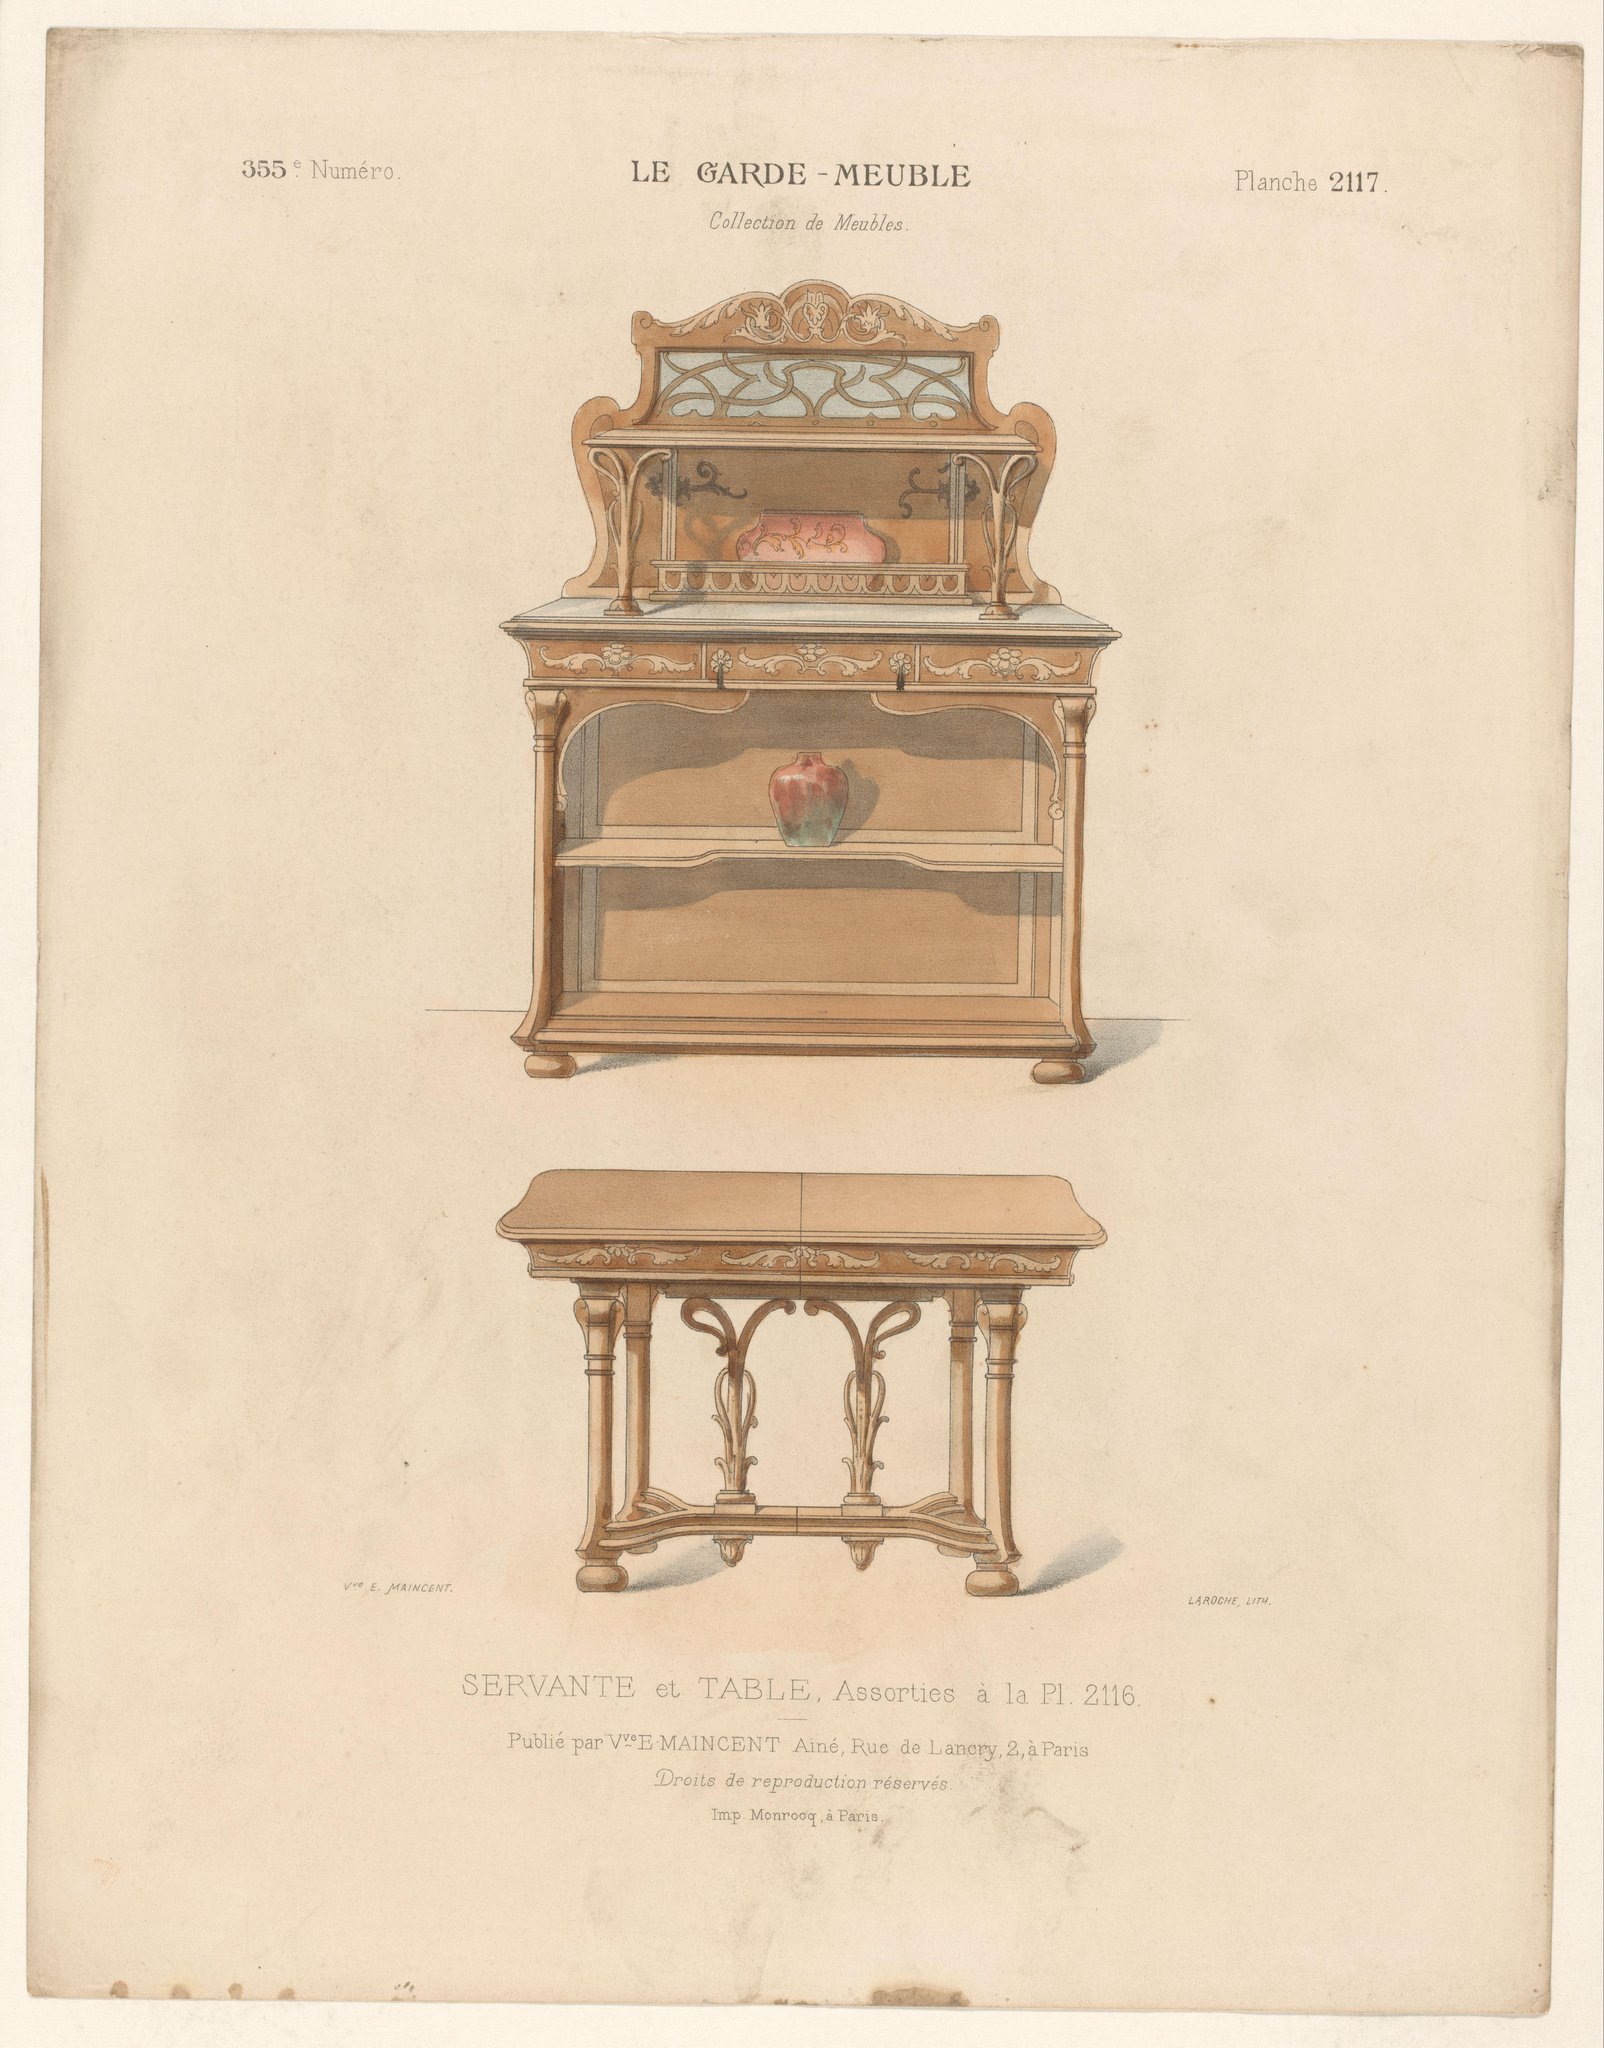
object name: print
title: Le garde-meuble / Collection de Meubles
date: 1895-1935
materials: paper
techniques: hand coloring, lithograph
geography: paris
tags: furniture for storage, table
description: Ieder Livraison in de serie Le Garde-Meuble bevat negen platen: drie 'sièges' (zitmeubels), drie 'meubles' (diverse meubels zoals tafels en kasten) en drie 'tentures' (gordijnen en draperieën).